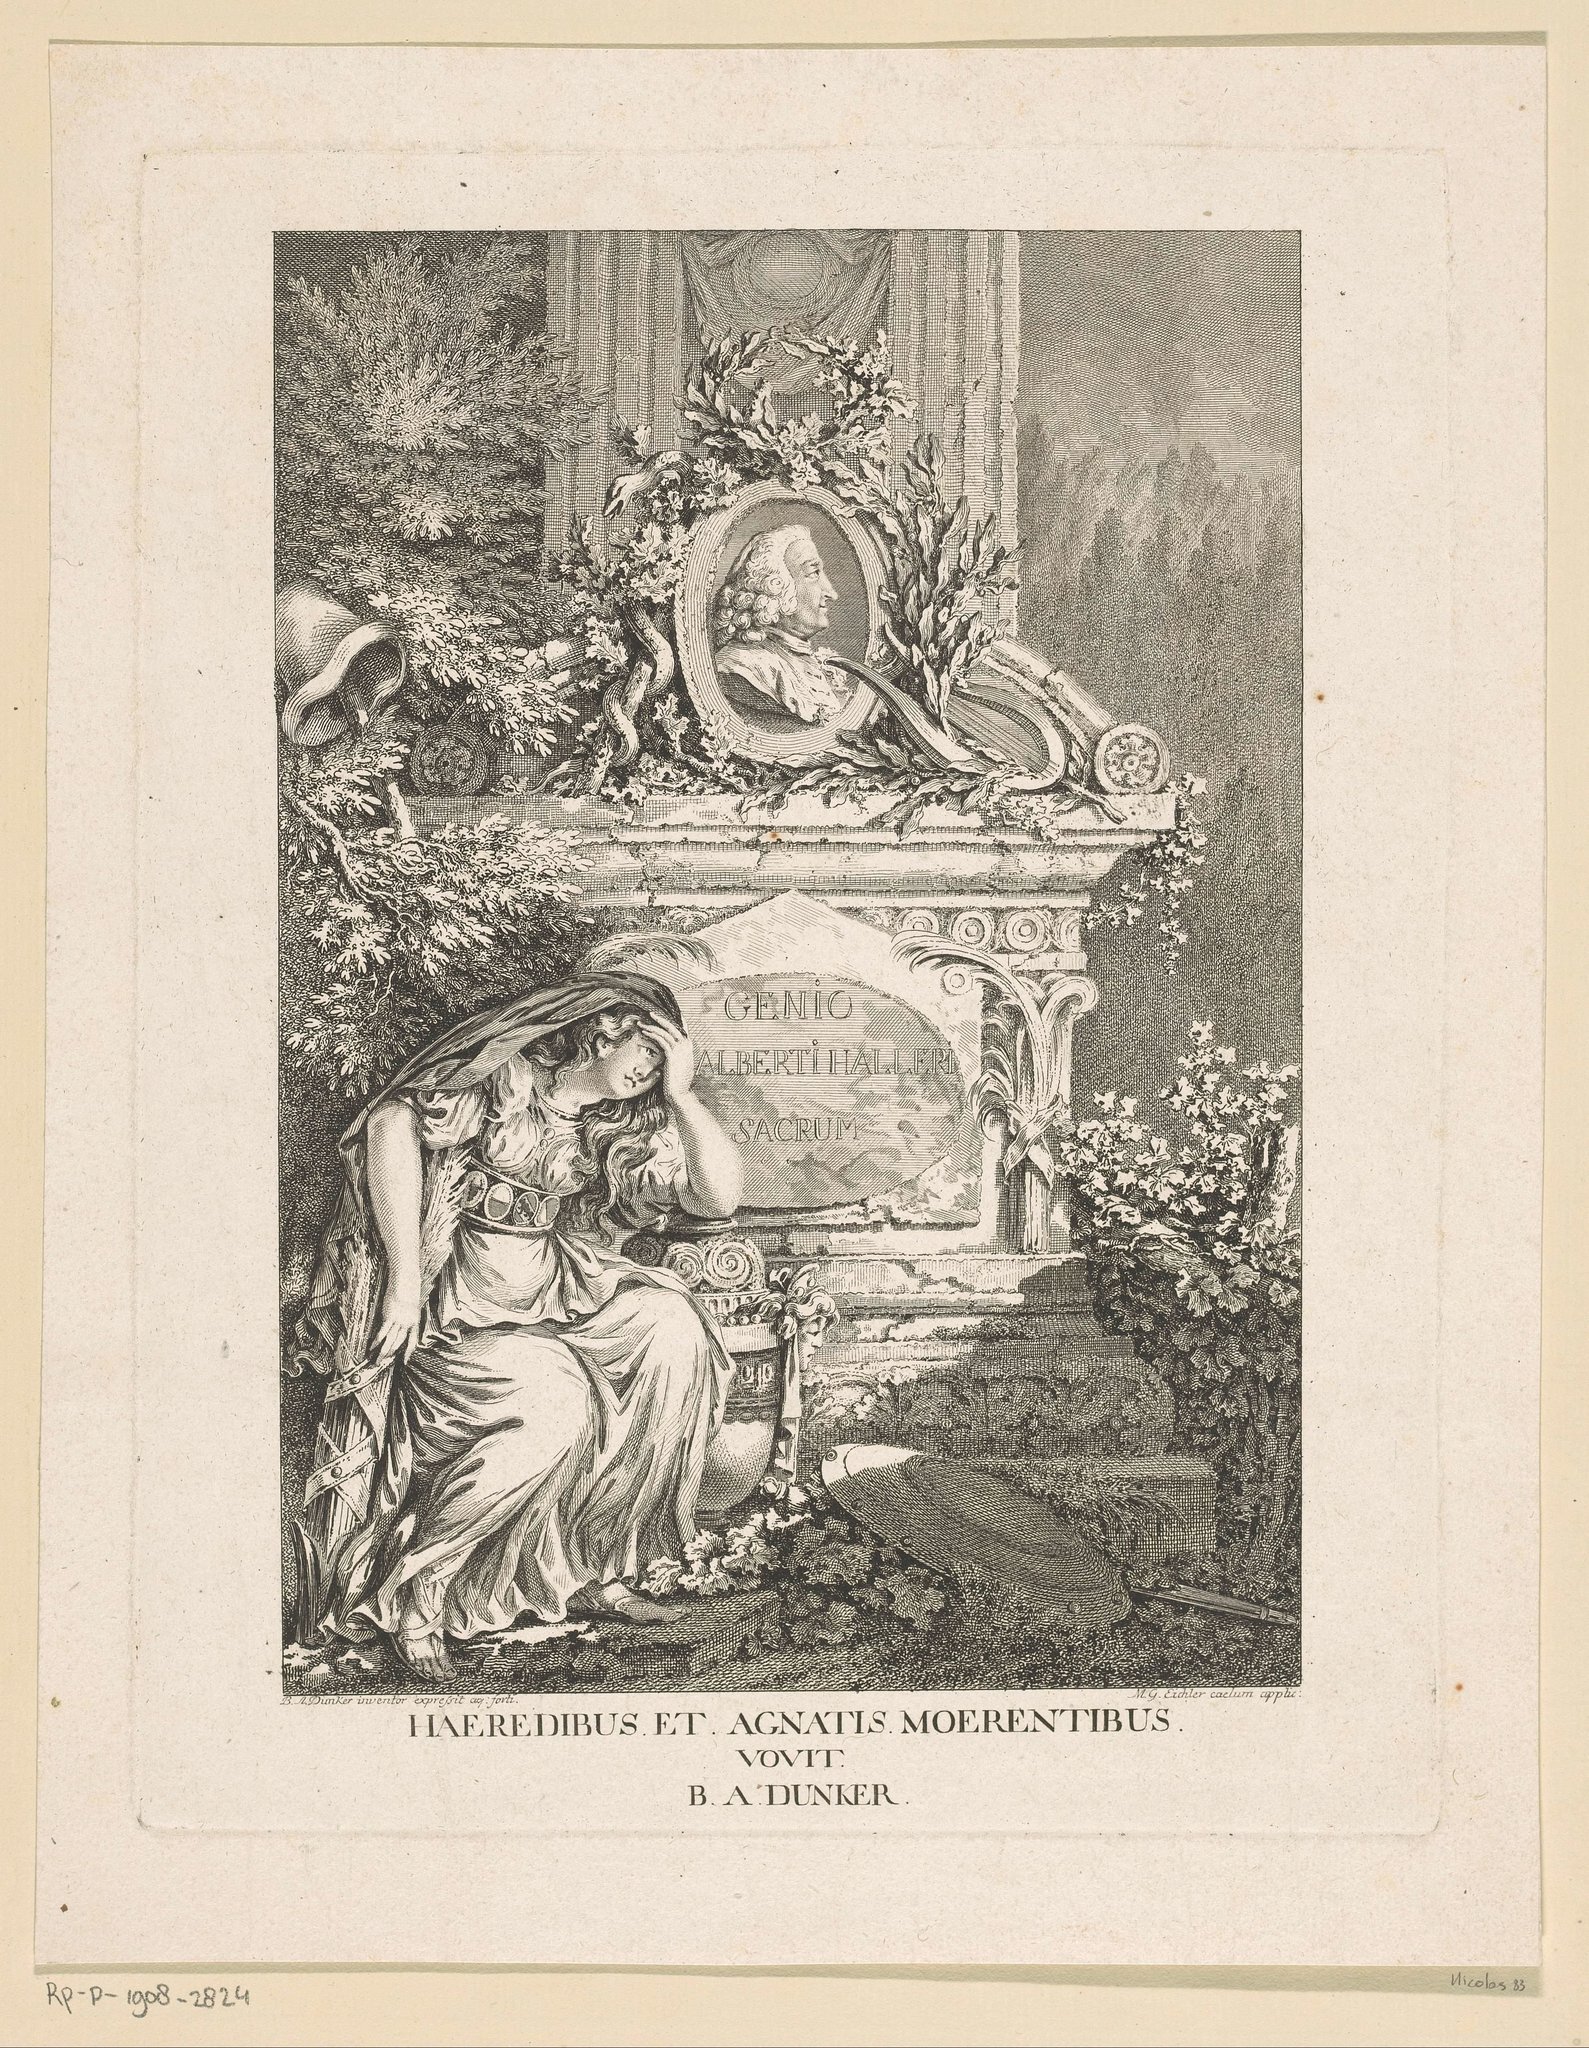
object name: print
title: Allegorie rond het grafmonument van Albrecht von Haller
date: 1777-1807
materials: paper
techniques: etching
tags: physicist, protective weapons: shield, adult woman, lyre, cithara, psaltery, historical persons, neck-gear ~ clothing, aesculapian sign, grave, tomb and other grave-forms and grave-markers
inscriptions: collector's mark: Lugt 2228